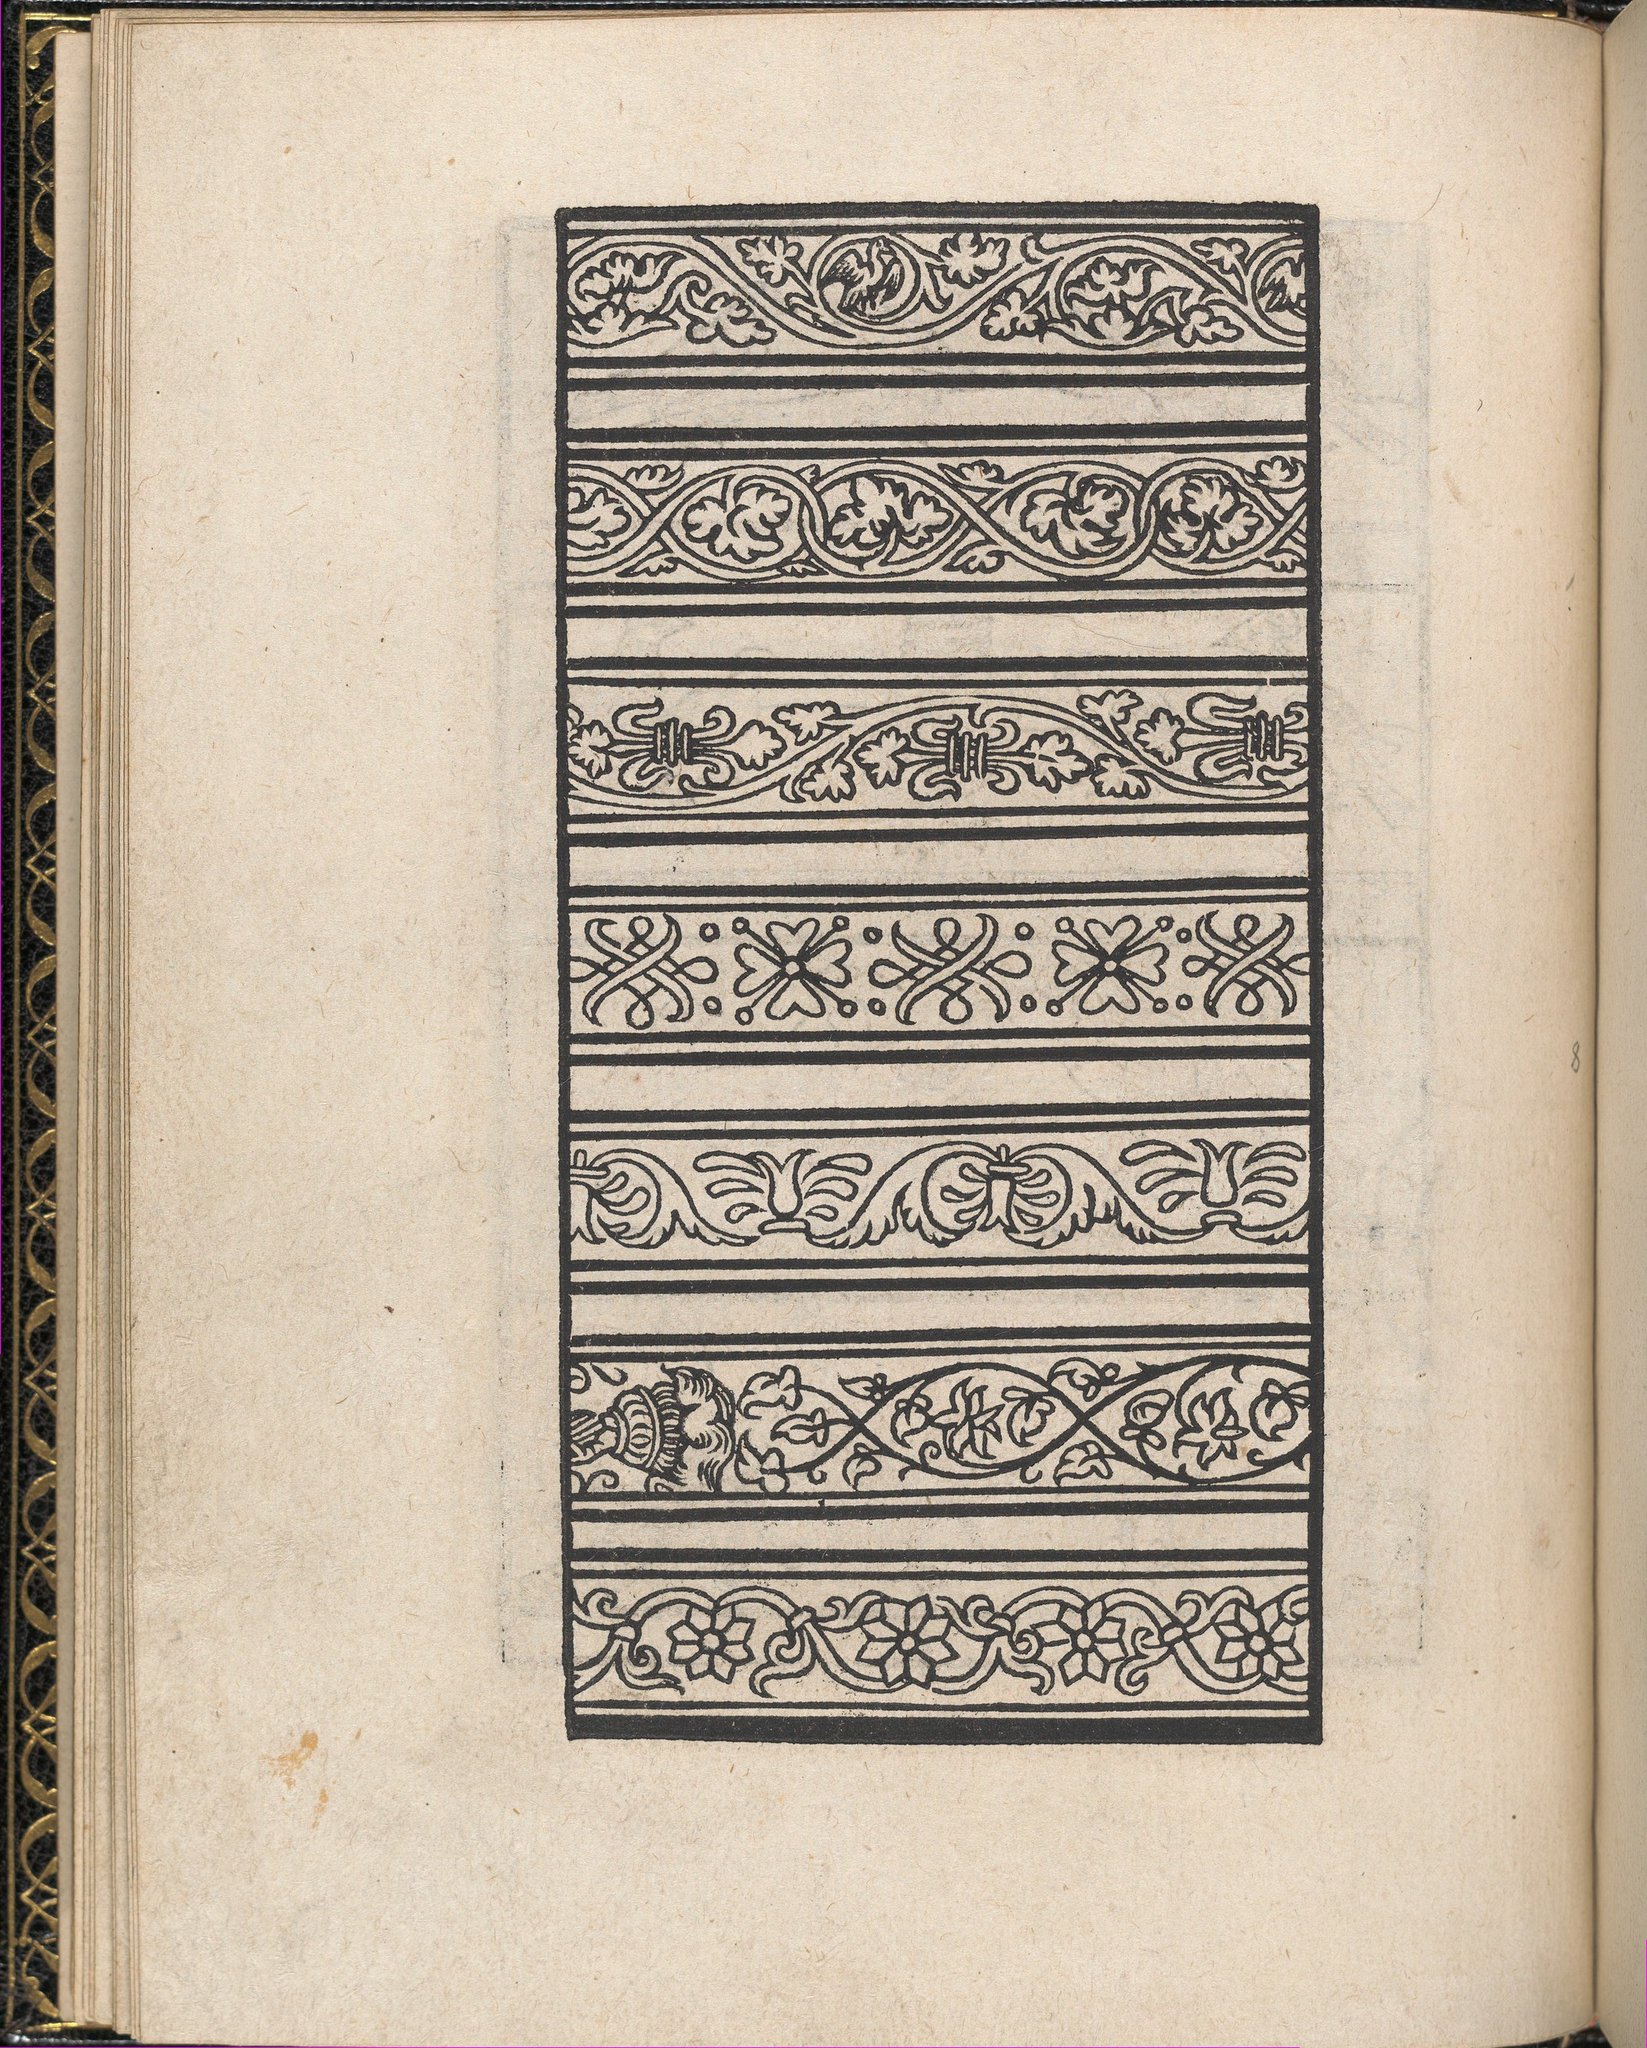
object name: book print ornament architecture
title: Page from Ein new kunstlich Modelbuch...(Page 8v)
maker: peter quentel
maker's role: publisher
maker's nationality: german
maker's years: 1500-1550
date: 1544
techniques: woodcut